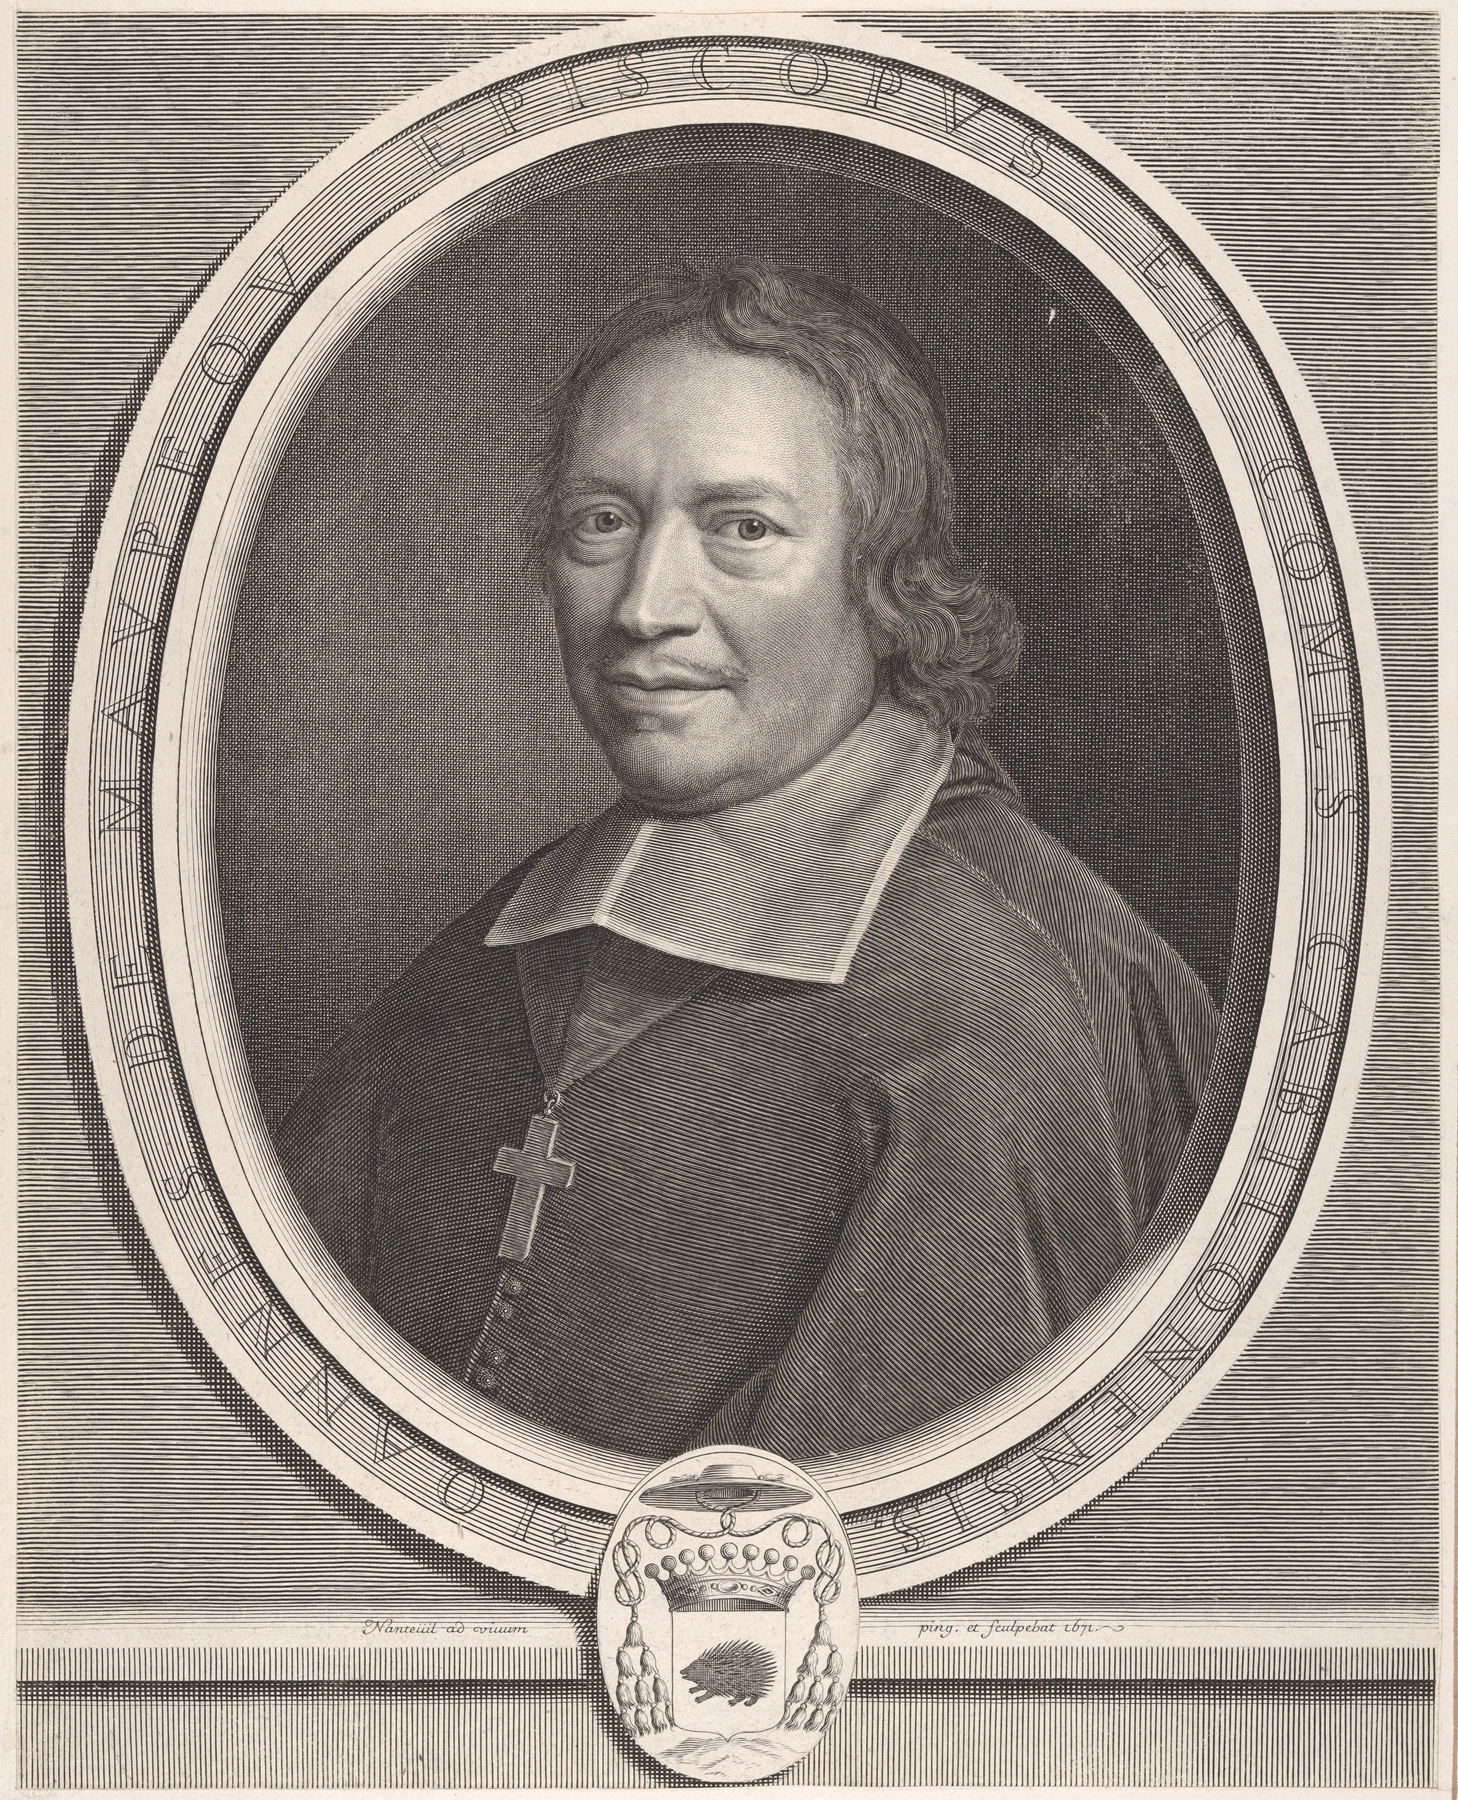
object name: print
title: Jean de Maupeou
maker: robert nanteuil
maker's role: artist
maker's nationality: french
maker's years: 1623-1678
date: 1671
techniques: engraving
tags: men,portraits,cross,coat of arms